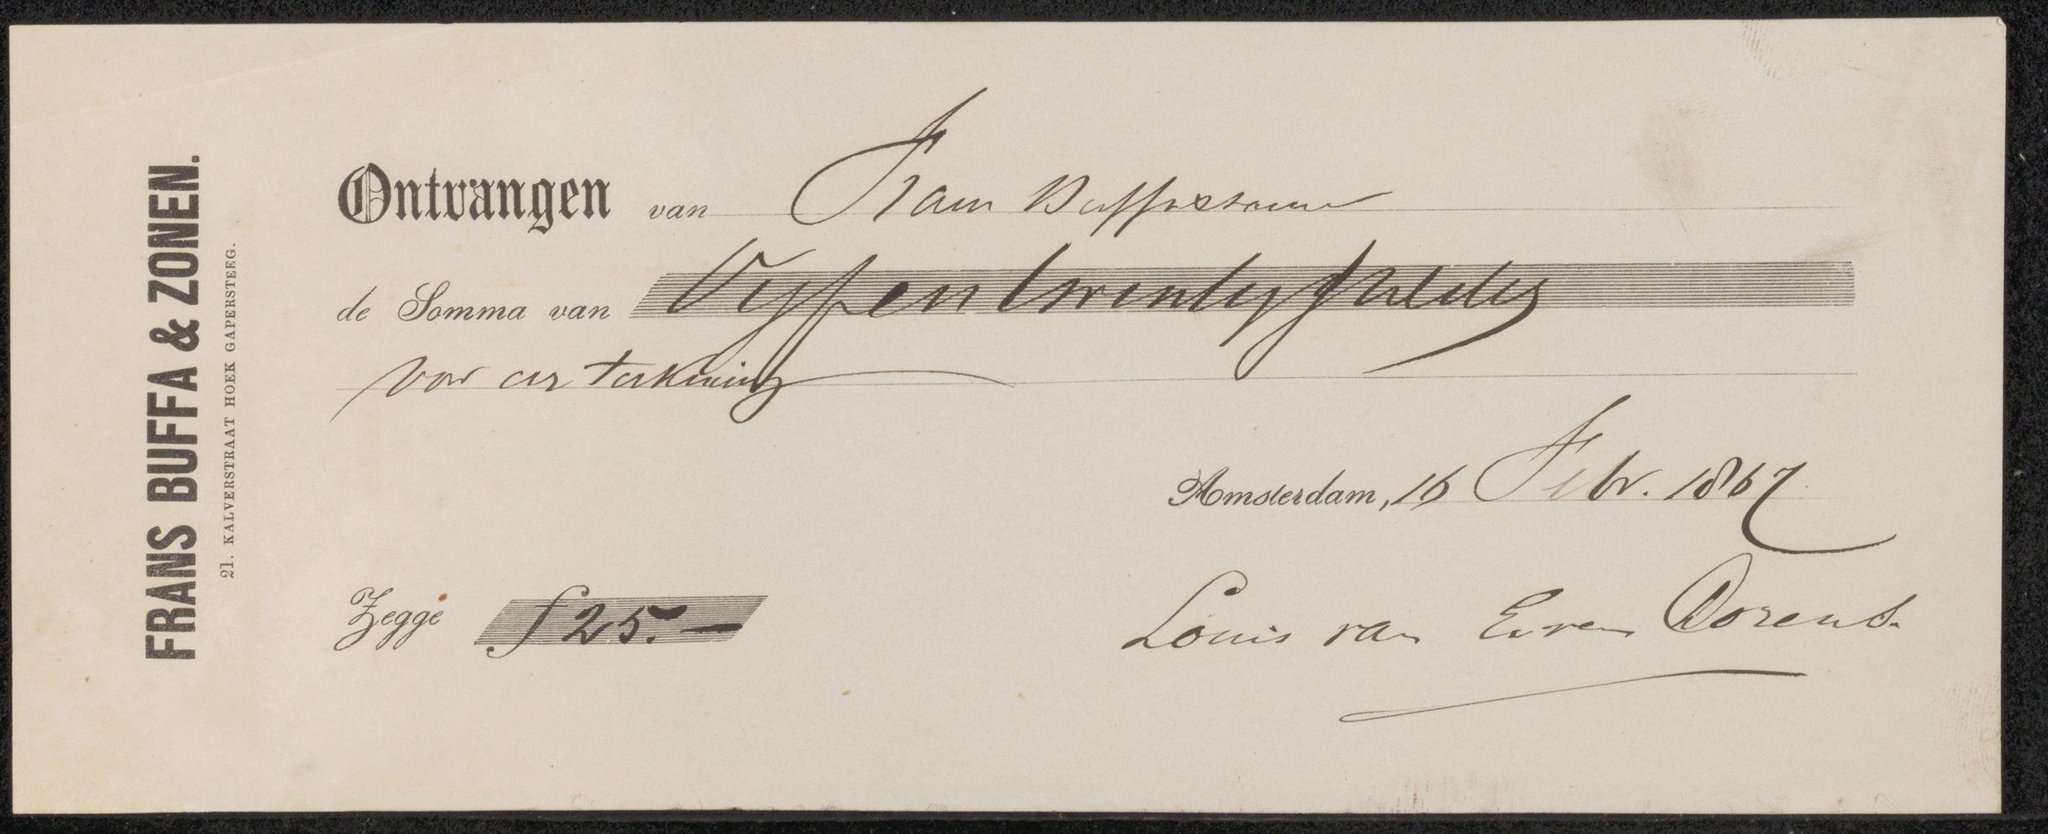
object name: ontvangstbewijs, kwitantie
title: Kwitantie voor Ludovicus Johannes van Erven Dorens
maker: ludovicus johannes van erven dorens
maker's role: draughtsman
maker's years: 1832-1897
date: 1867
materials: ink, paper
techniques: pen, printing, writing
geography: amsterdam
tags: drawing, money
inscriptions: collector's mark: Lugt 2233